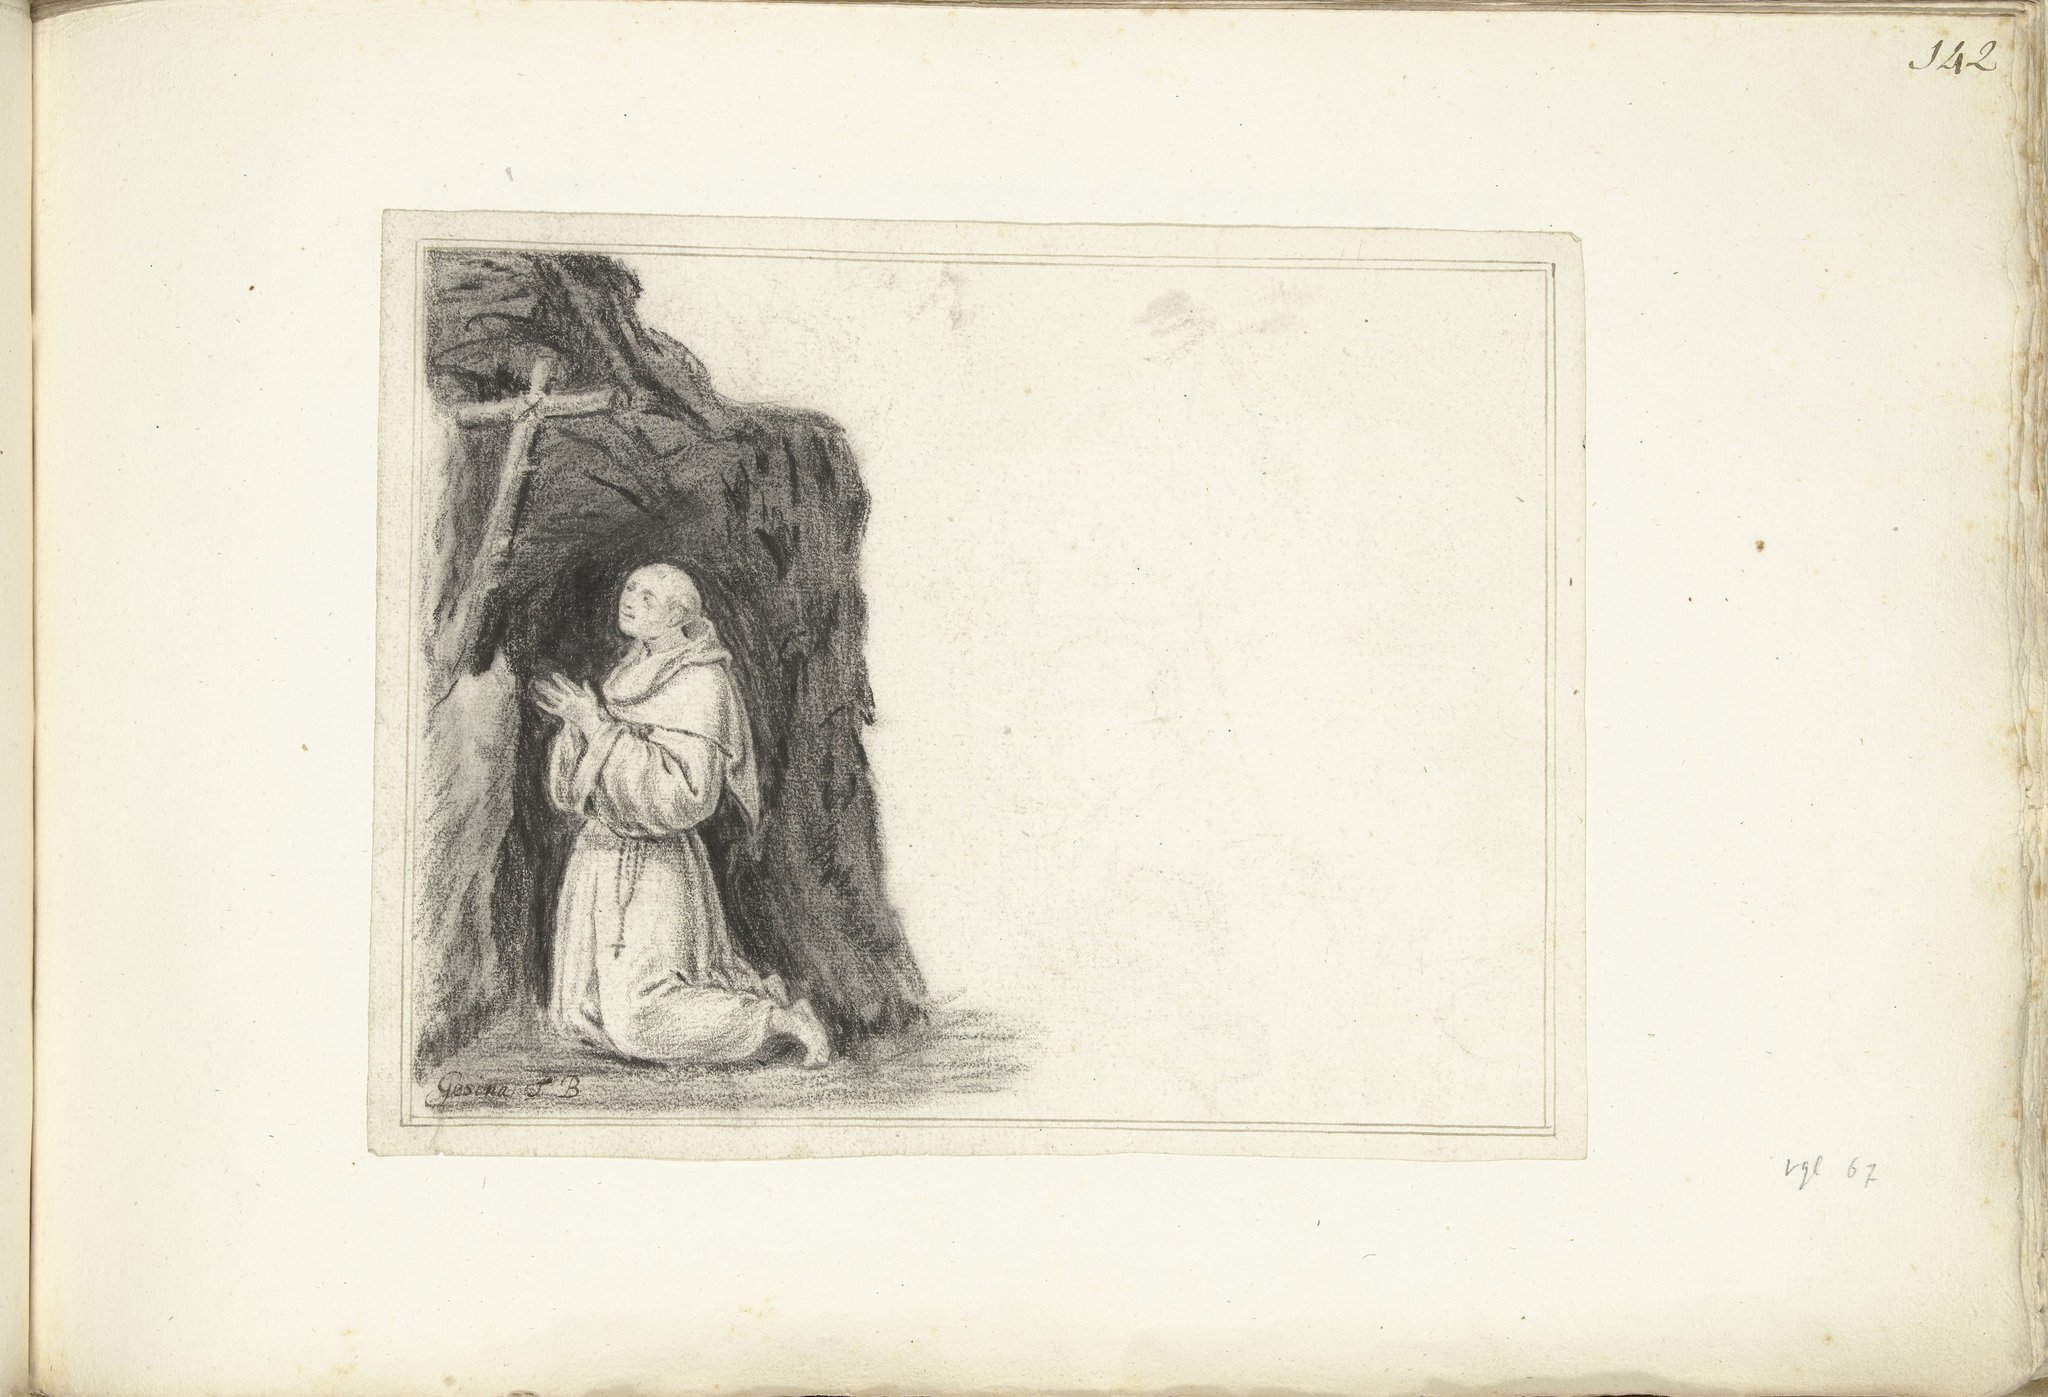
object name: drawing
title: Biddende monnik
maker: gesina ter borch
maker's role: draughtsman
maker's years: 1633-1690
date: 1643-1687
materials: chalk, paper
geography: zwolle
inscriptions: annotation: ‘vgl 67’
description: Tekening opgeplakt in het Familie-plakboek. Dezelfde figuur is afgebeeld op folio 67.